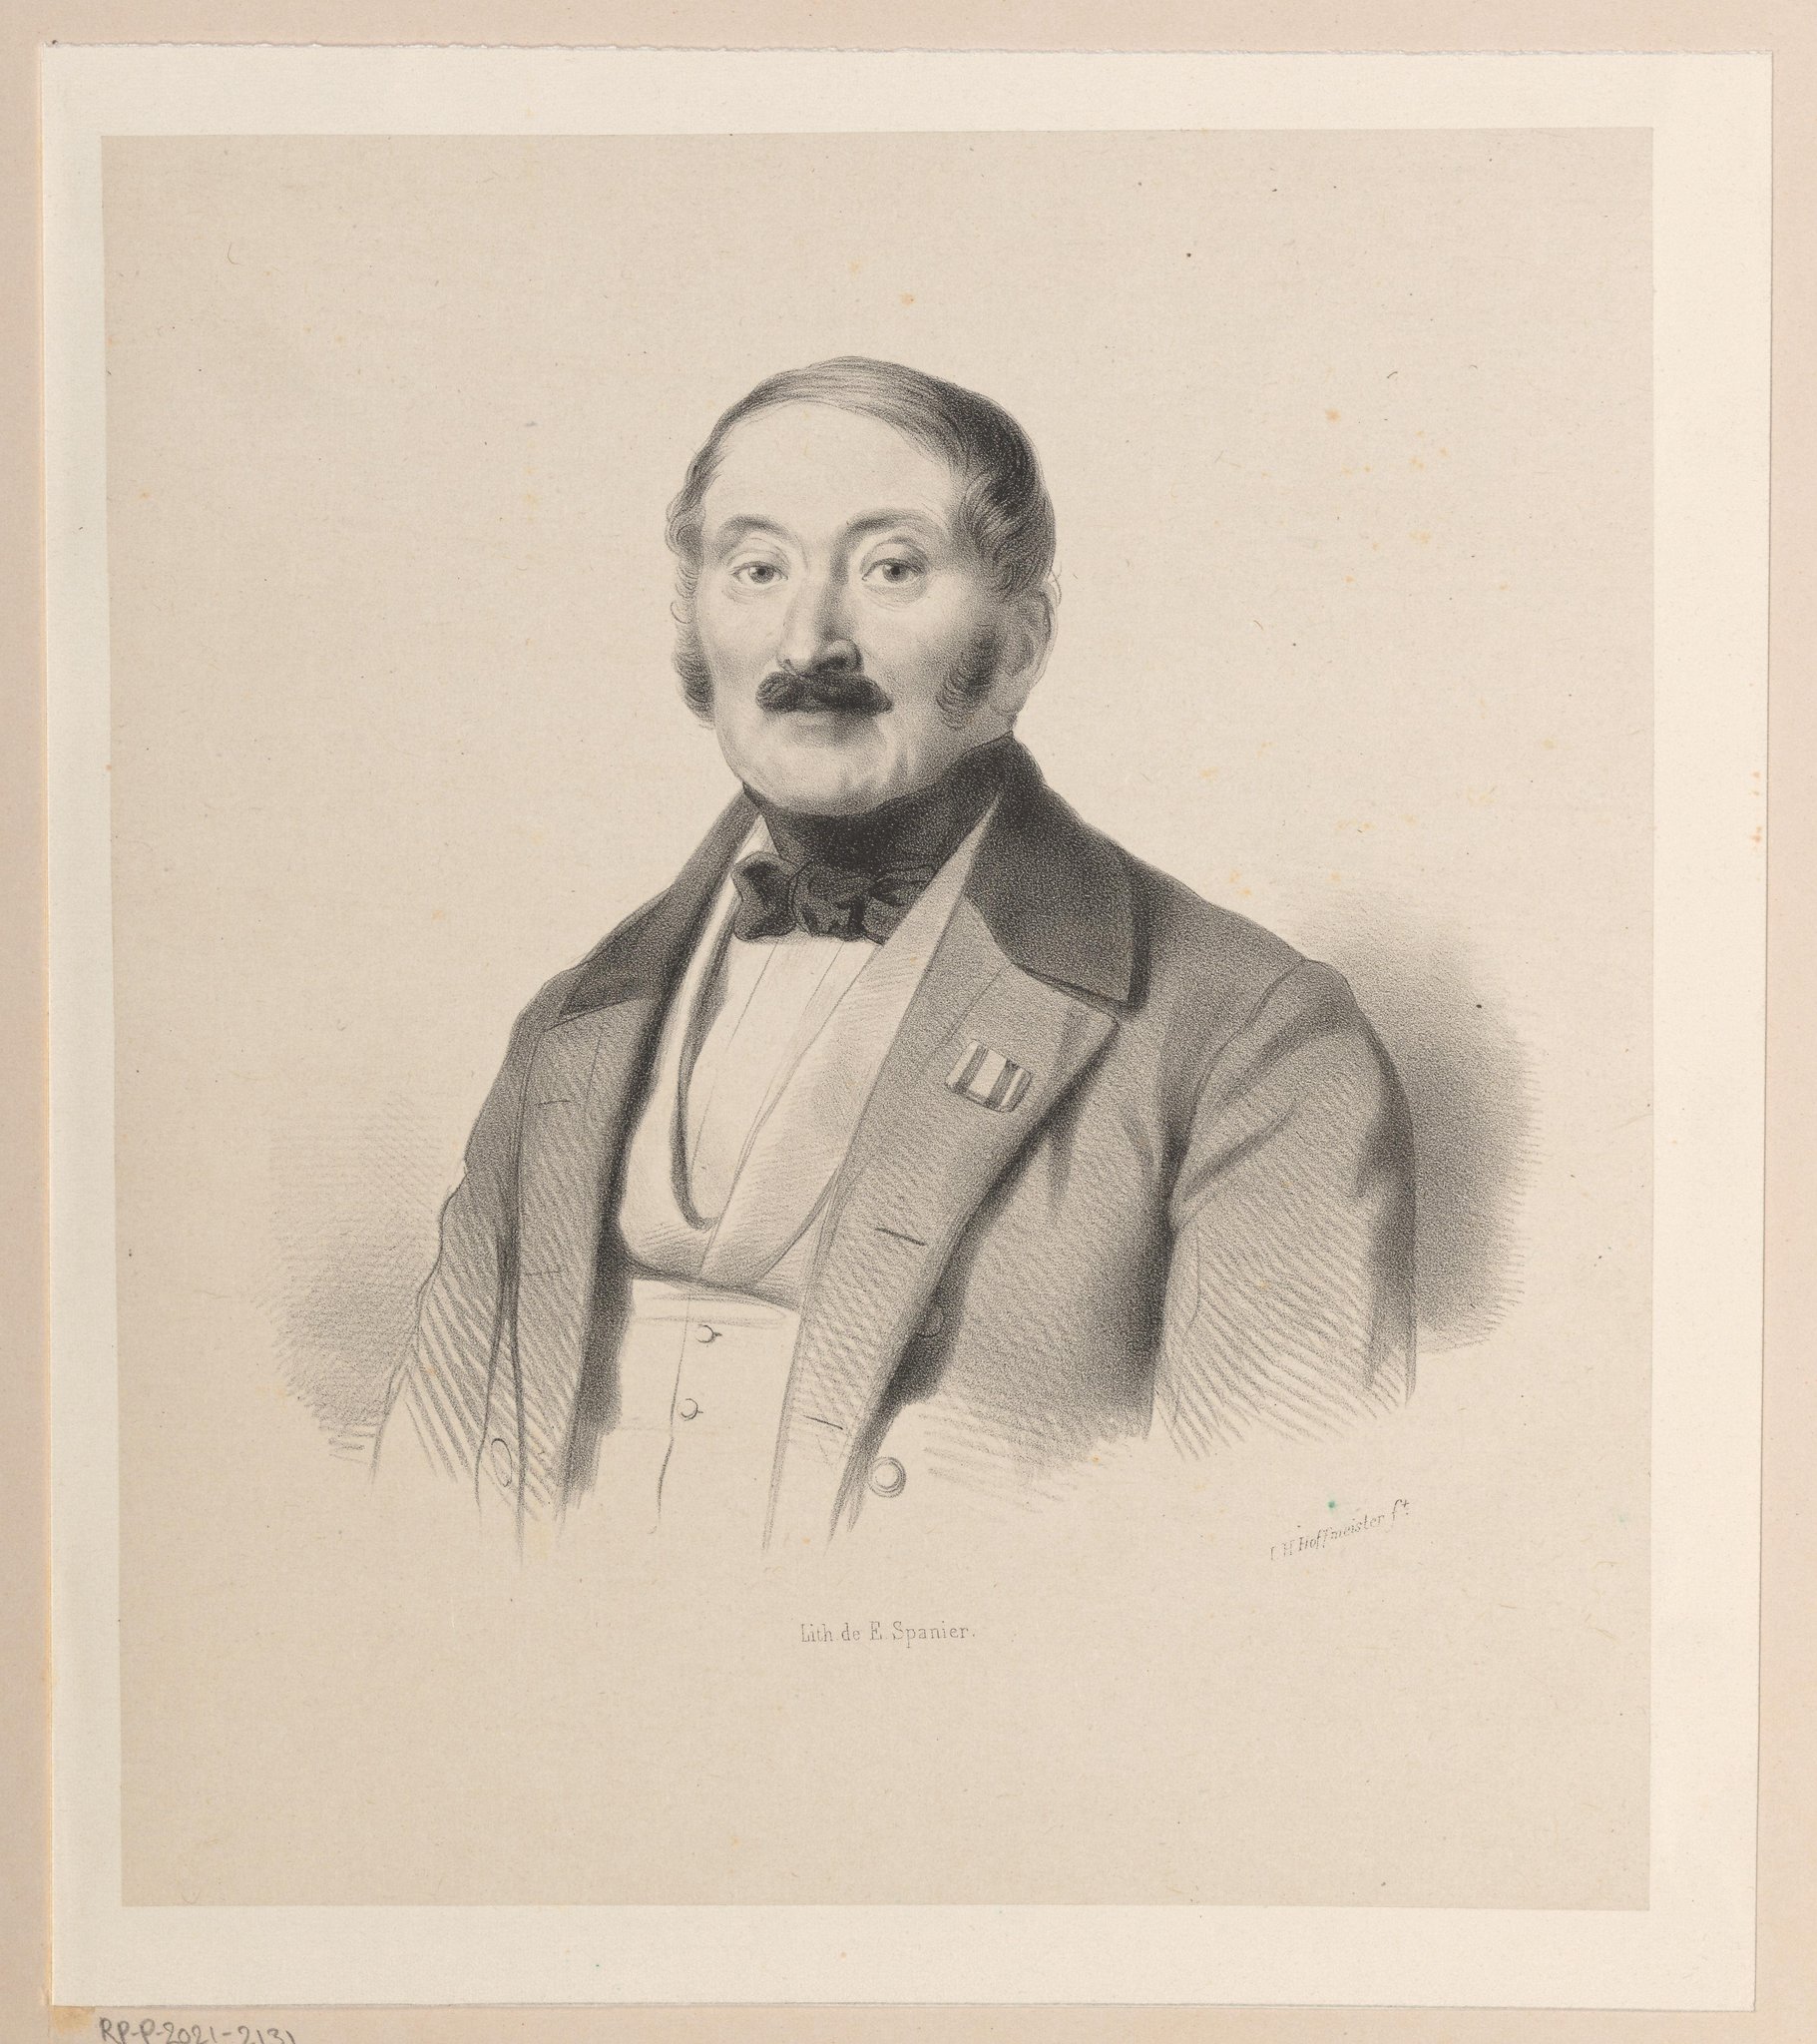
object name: print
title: Portret van jonkheer Rijnholt Antony Klerck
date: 1815-1899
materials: paper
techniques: lithograph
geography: the hague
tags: rhenen, historical persons